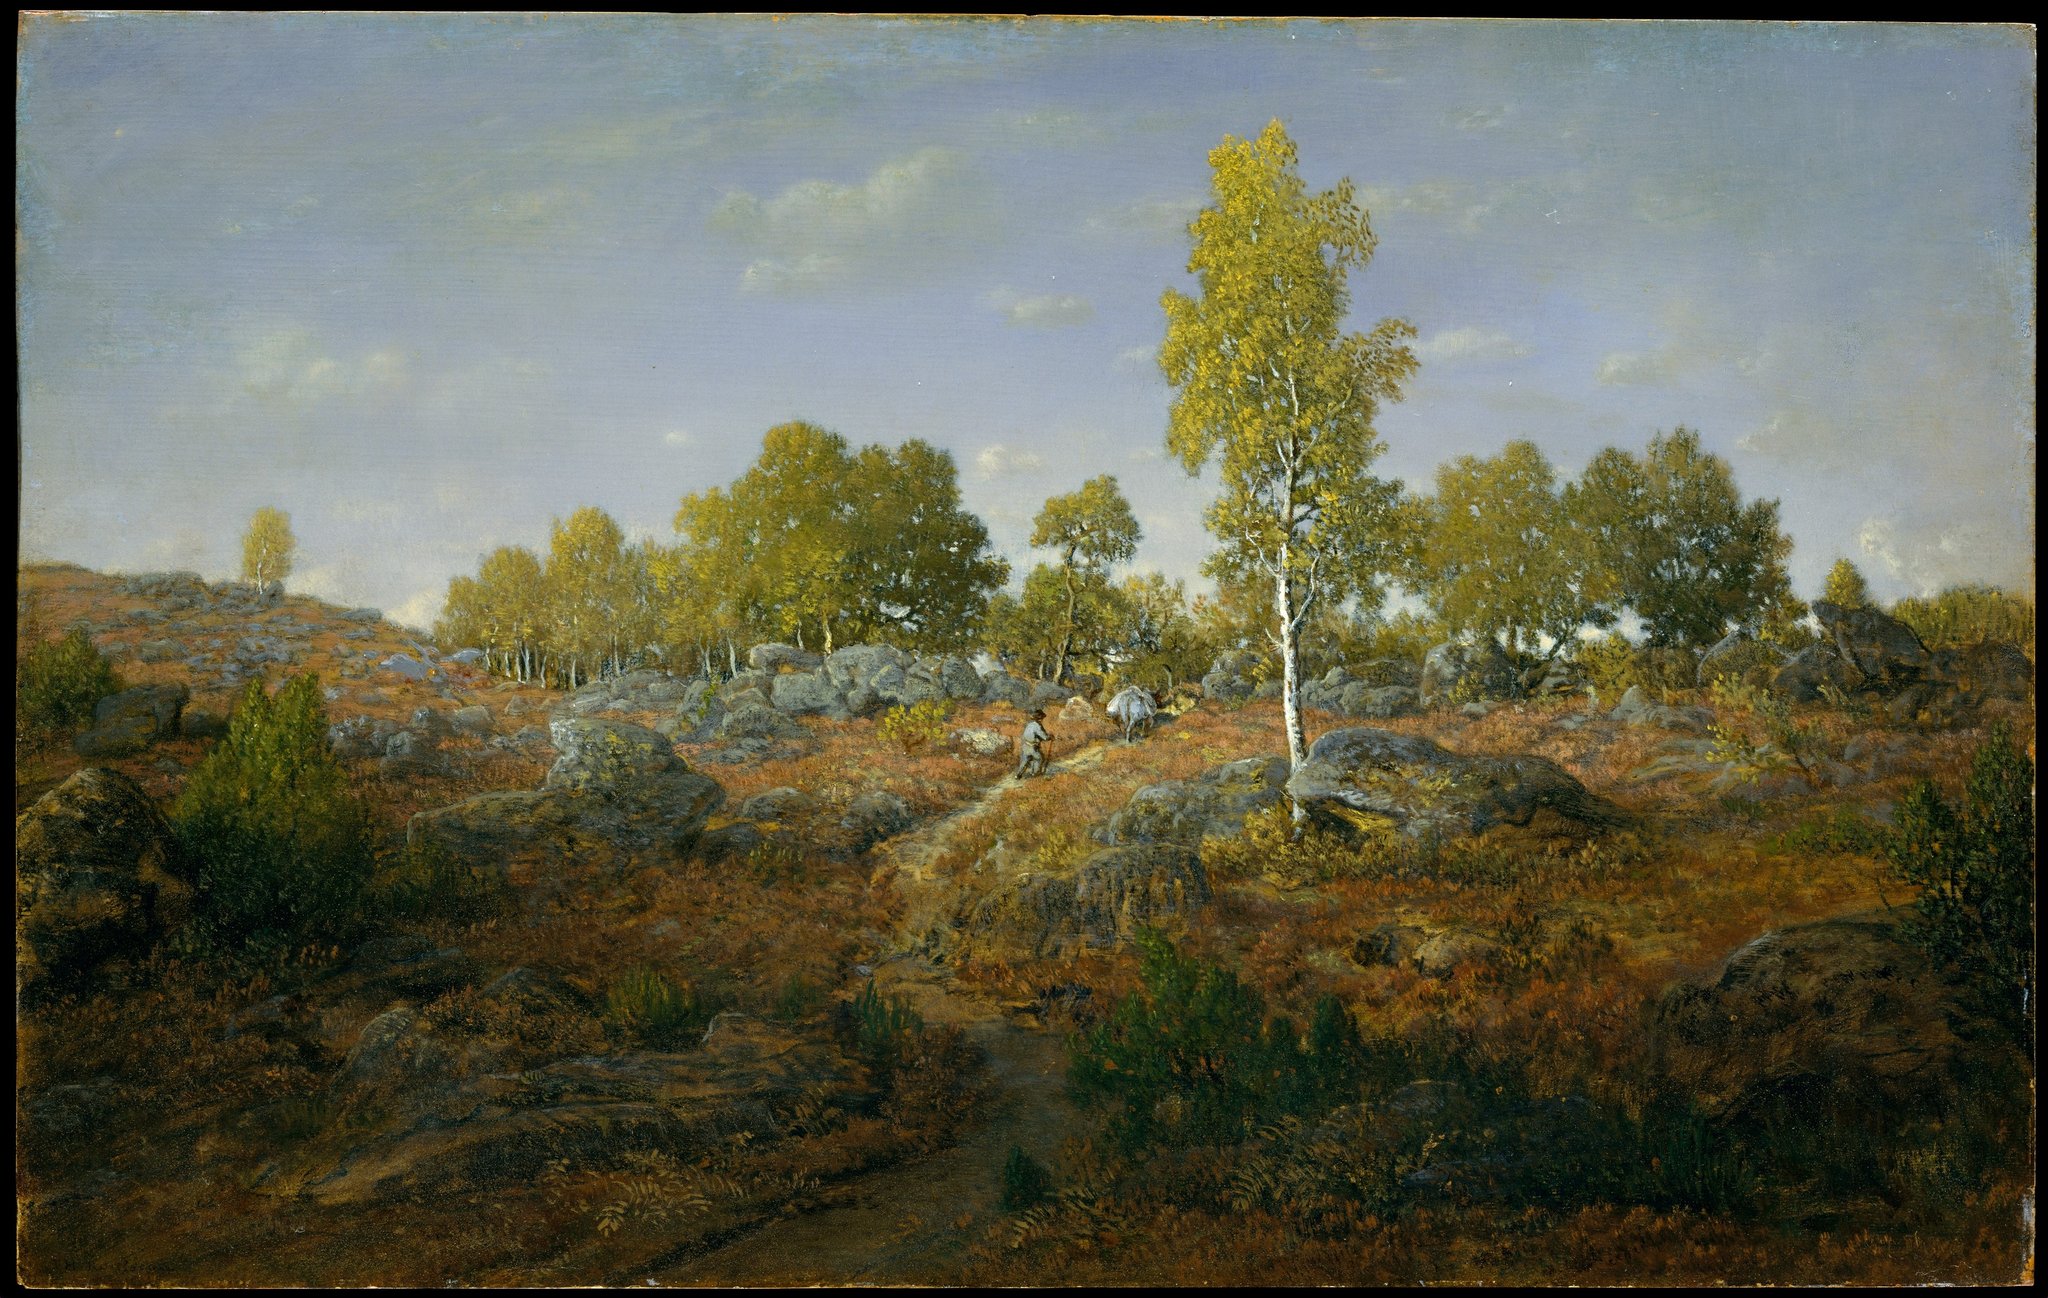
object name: painting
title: An Early Summer Morning in the Forest of Fontainebleau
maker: théodore rousseau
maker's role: artist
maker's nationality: french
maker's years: 1812-1867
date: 1861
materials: oil, wood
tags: landscapes